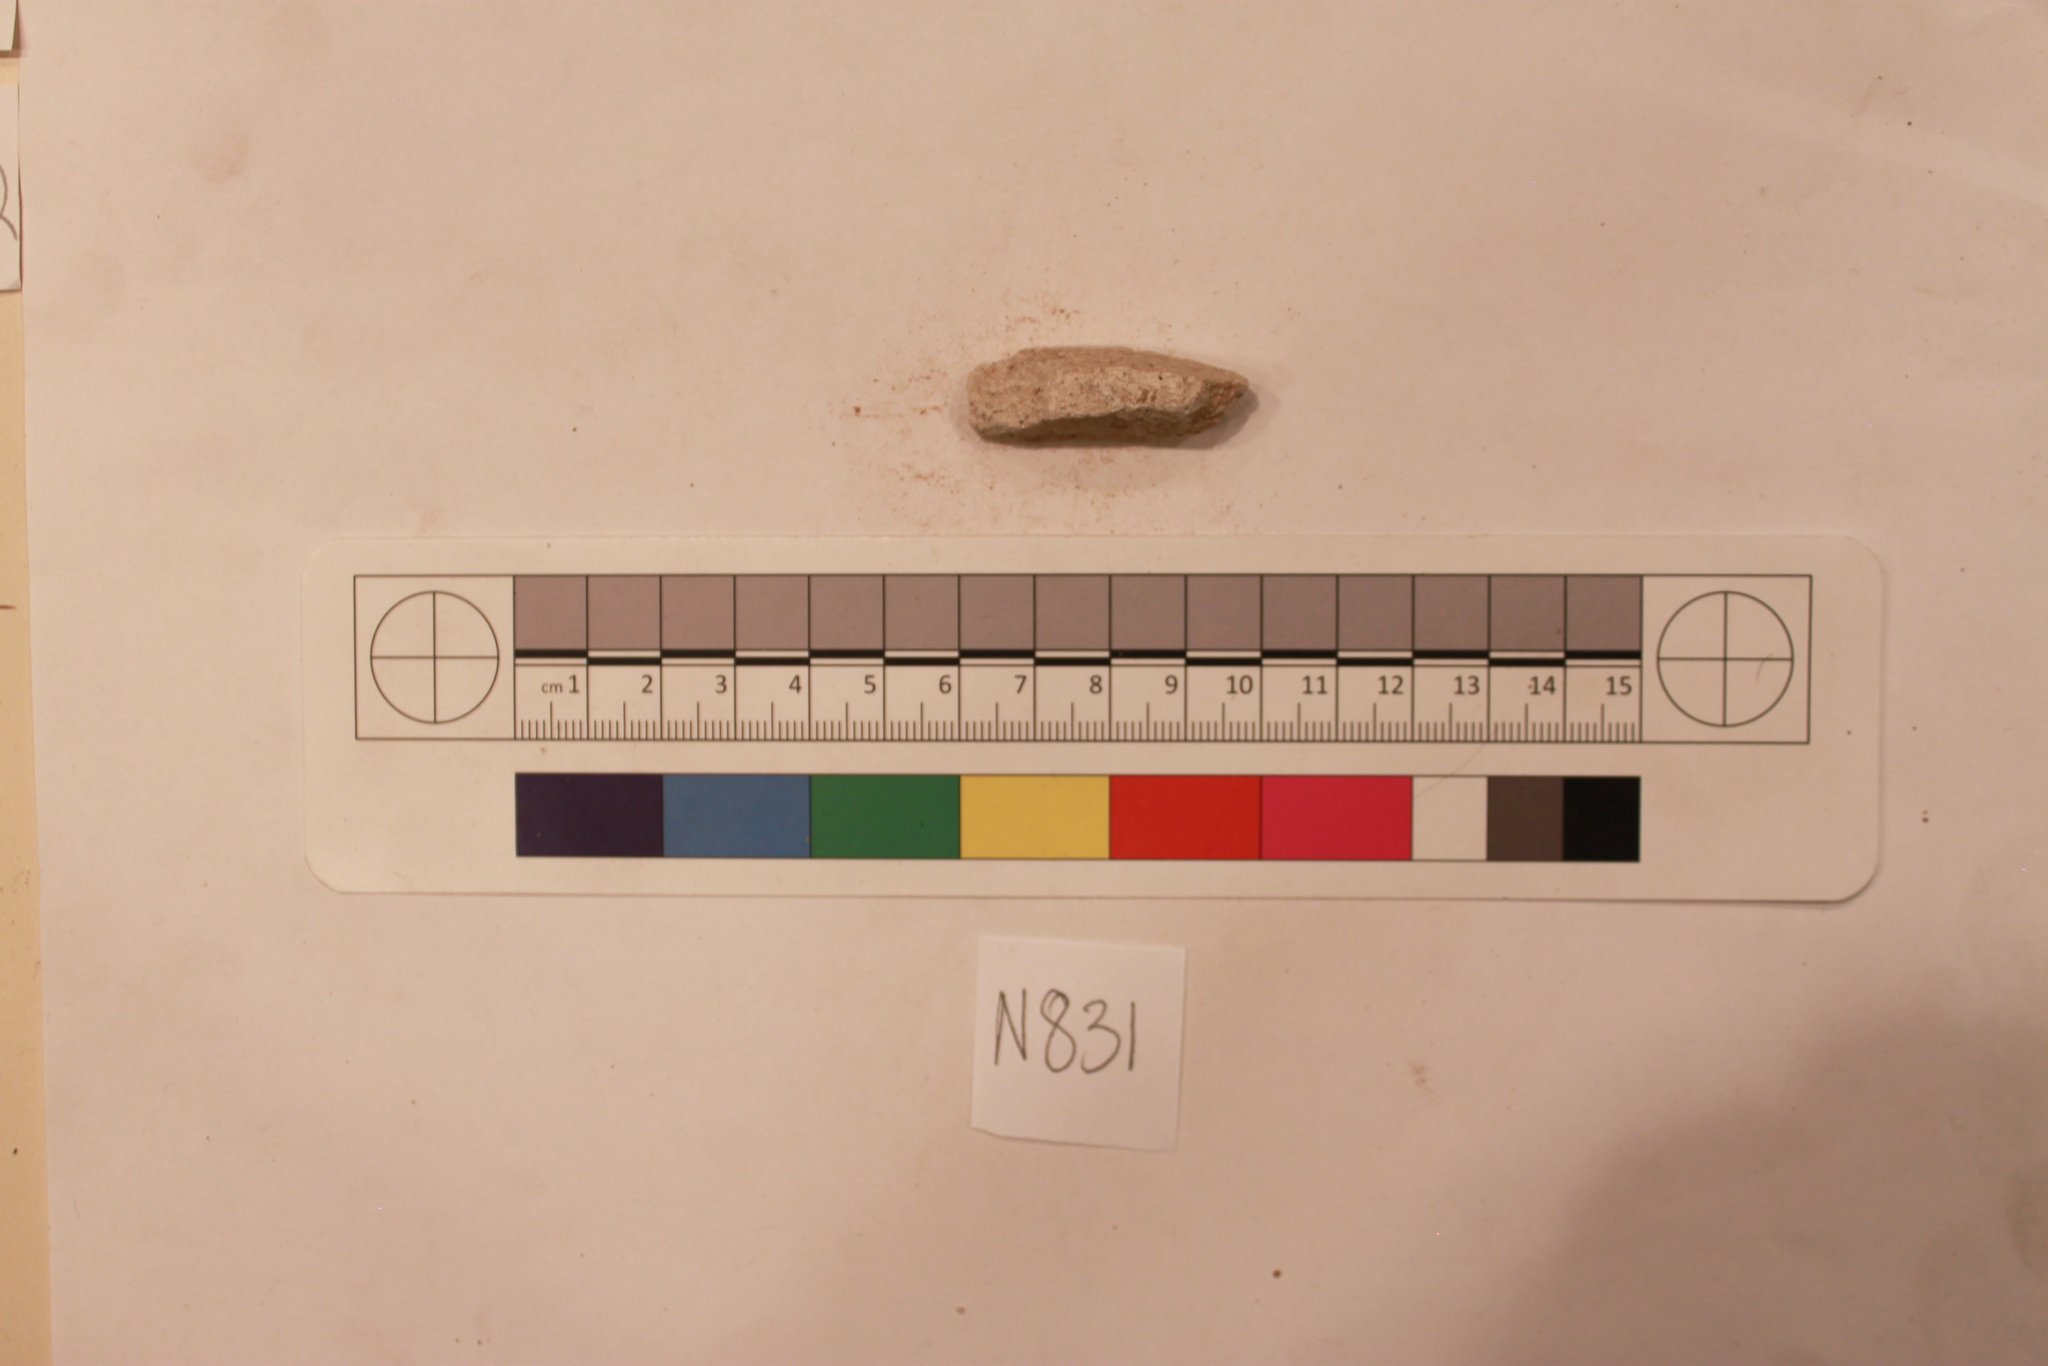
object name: fragment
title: Stucco Fragment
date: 701-1200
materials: plaster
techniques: carving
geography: iran